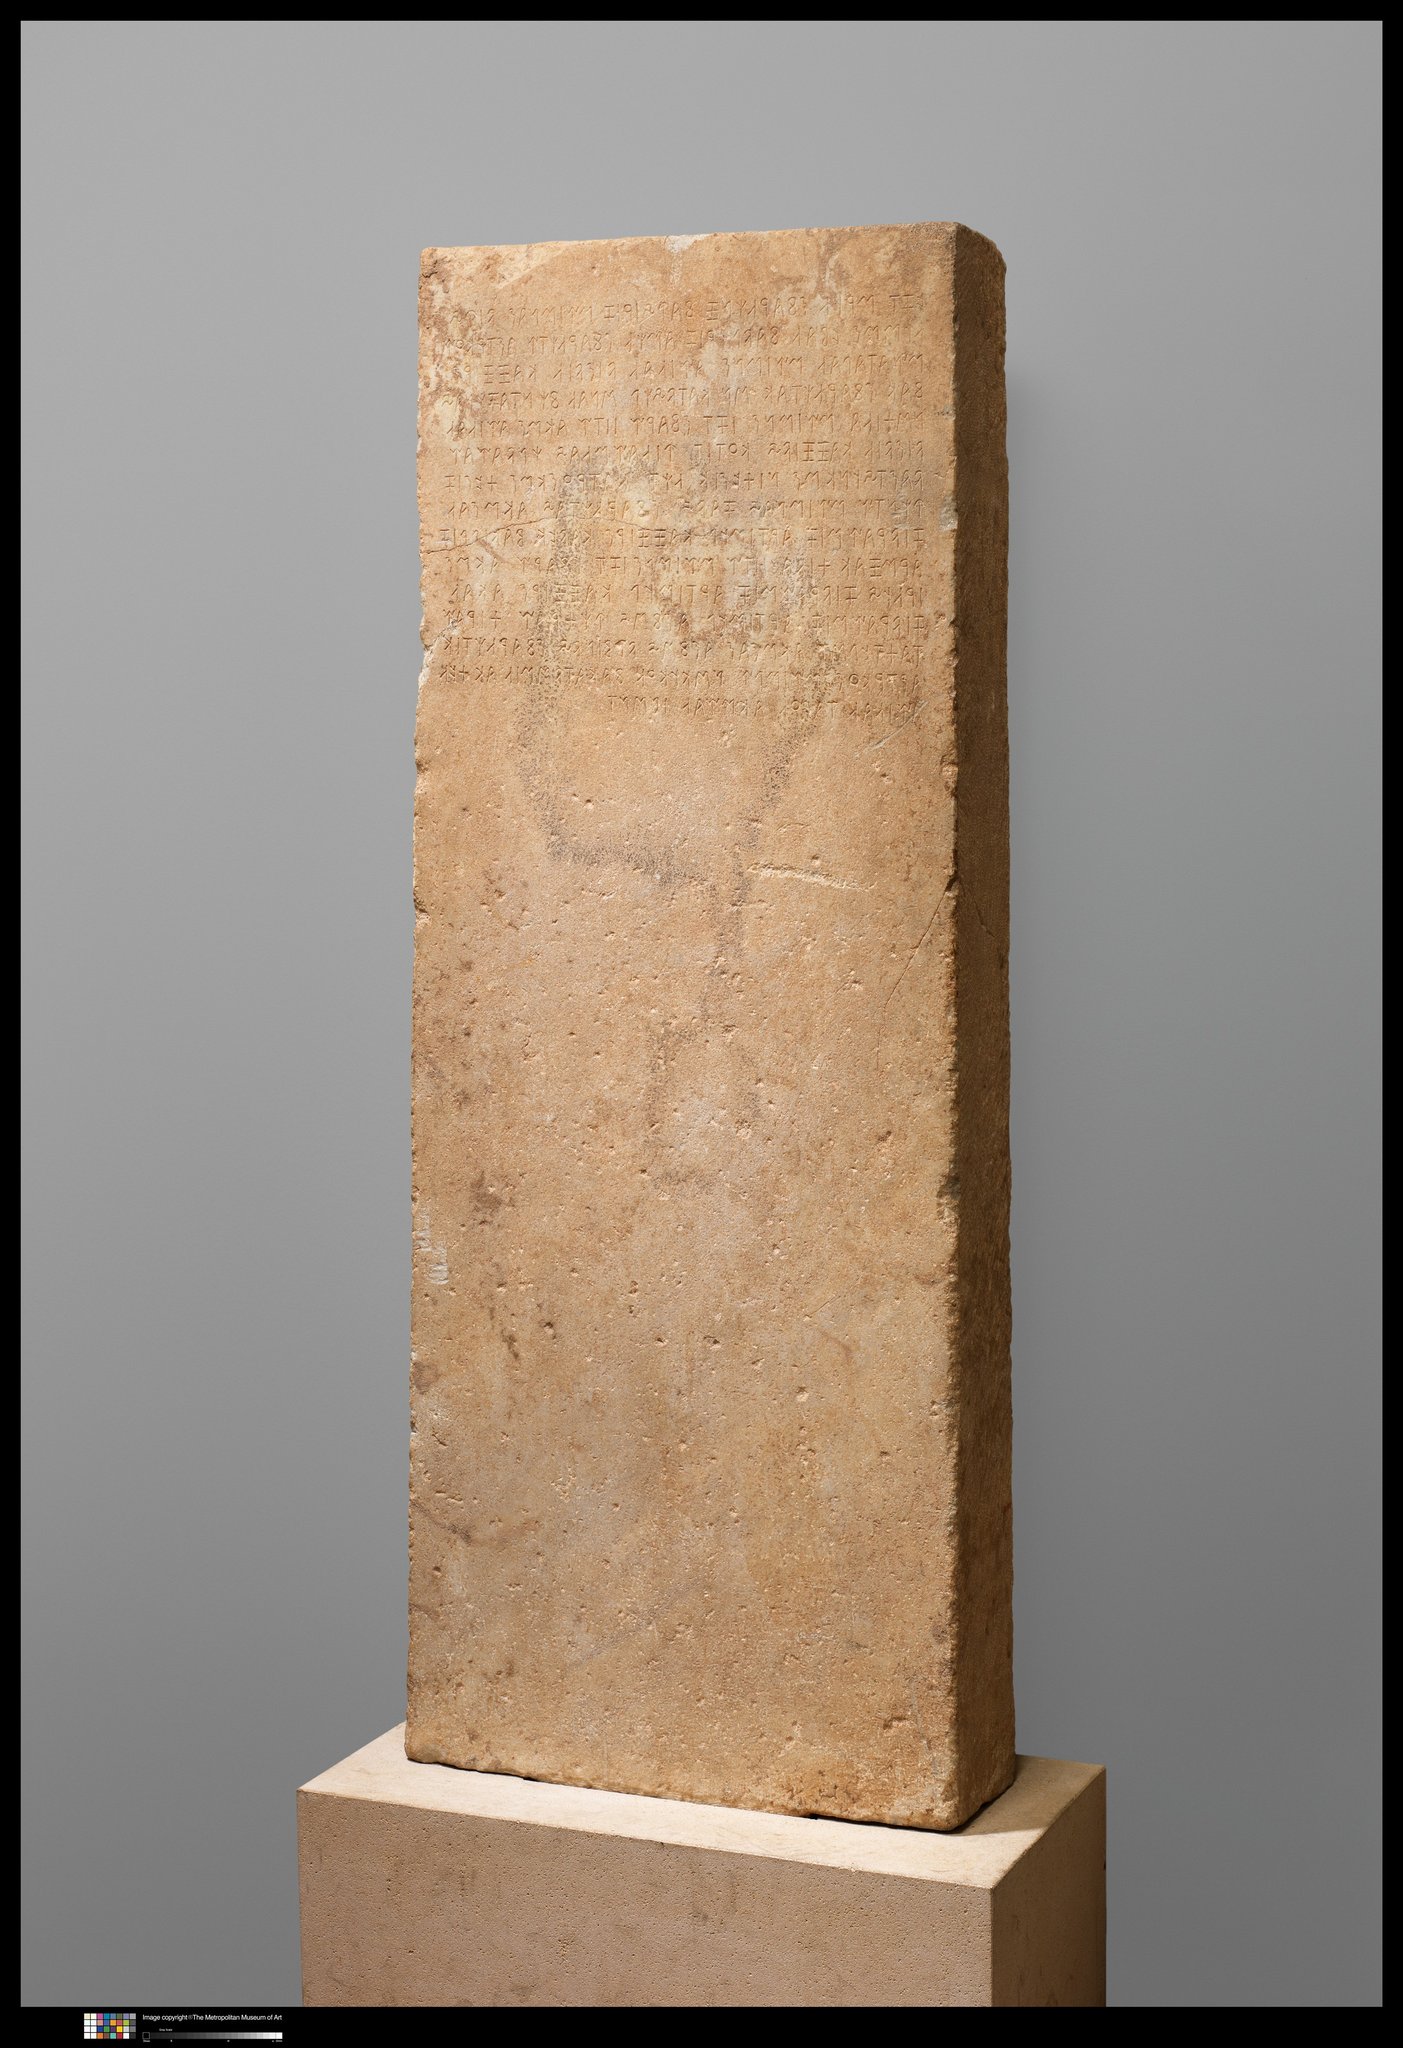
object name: stele with lydian inscription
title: Marble stele with a Lydian inscription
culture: lydian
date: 600-501 BCE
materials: marble